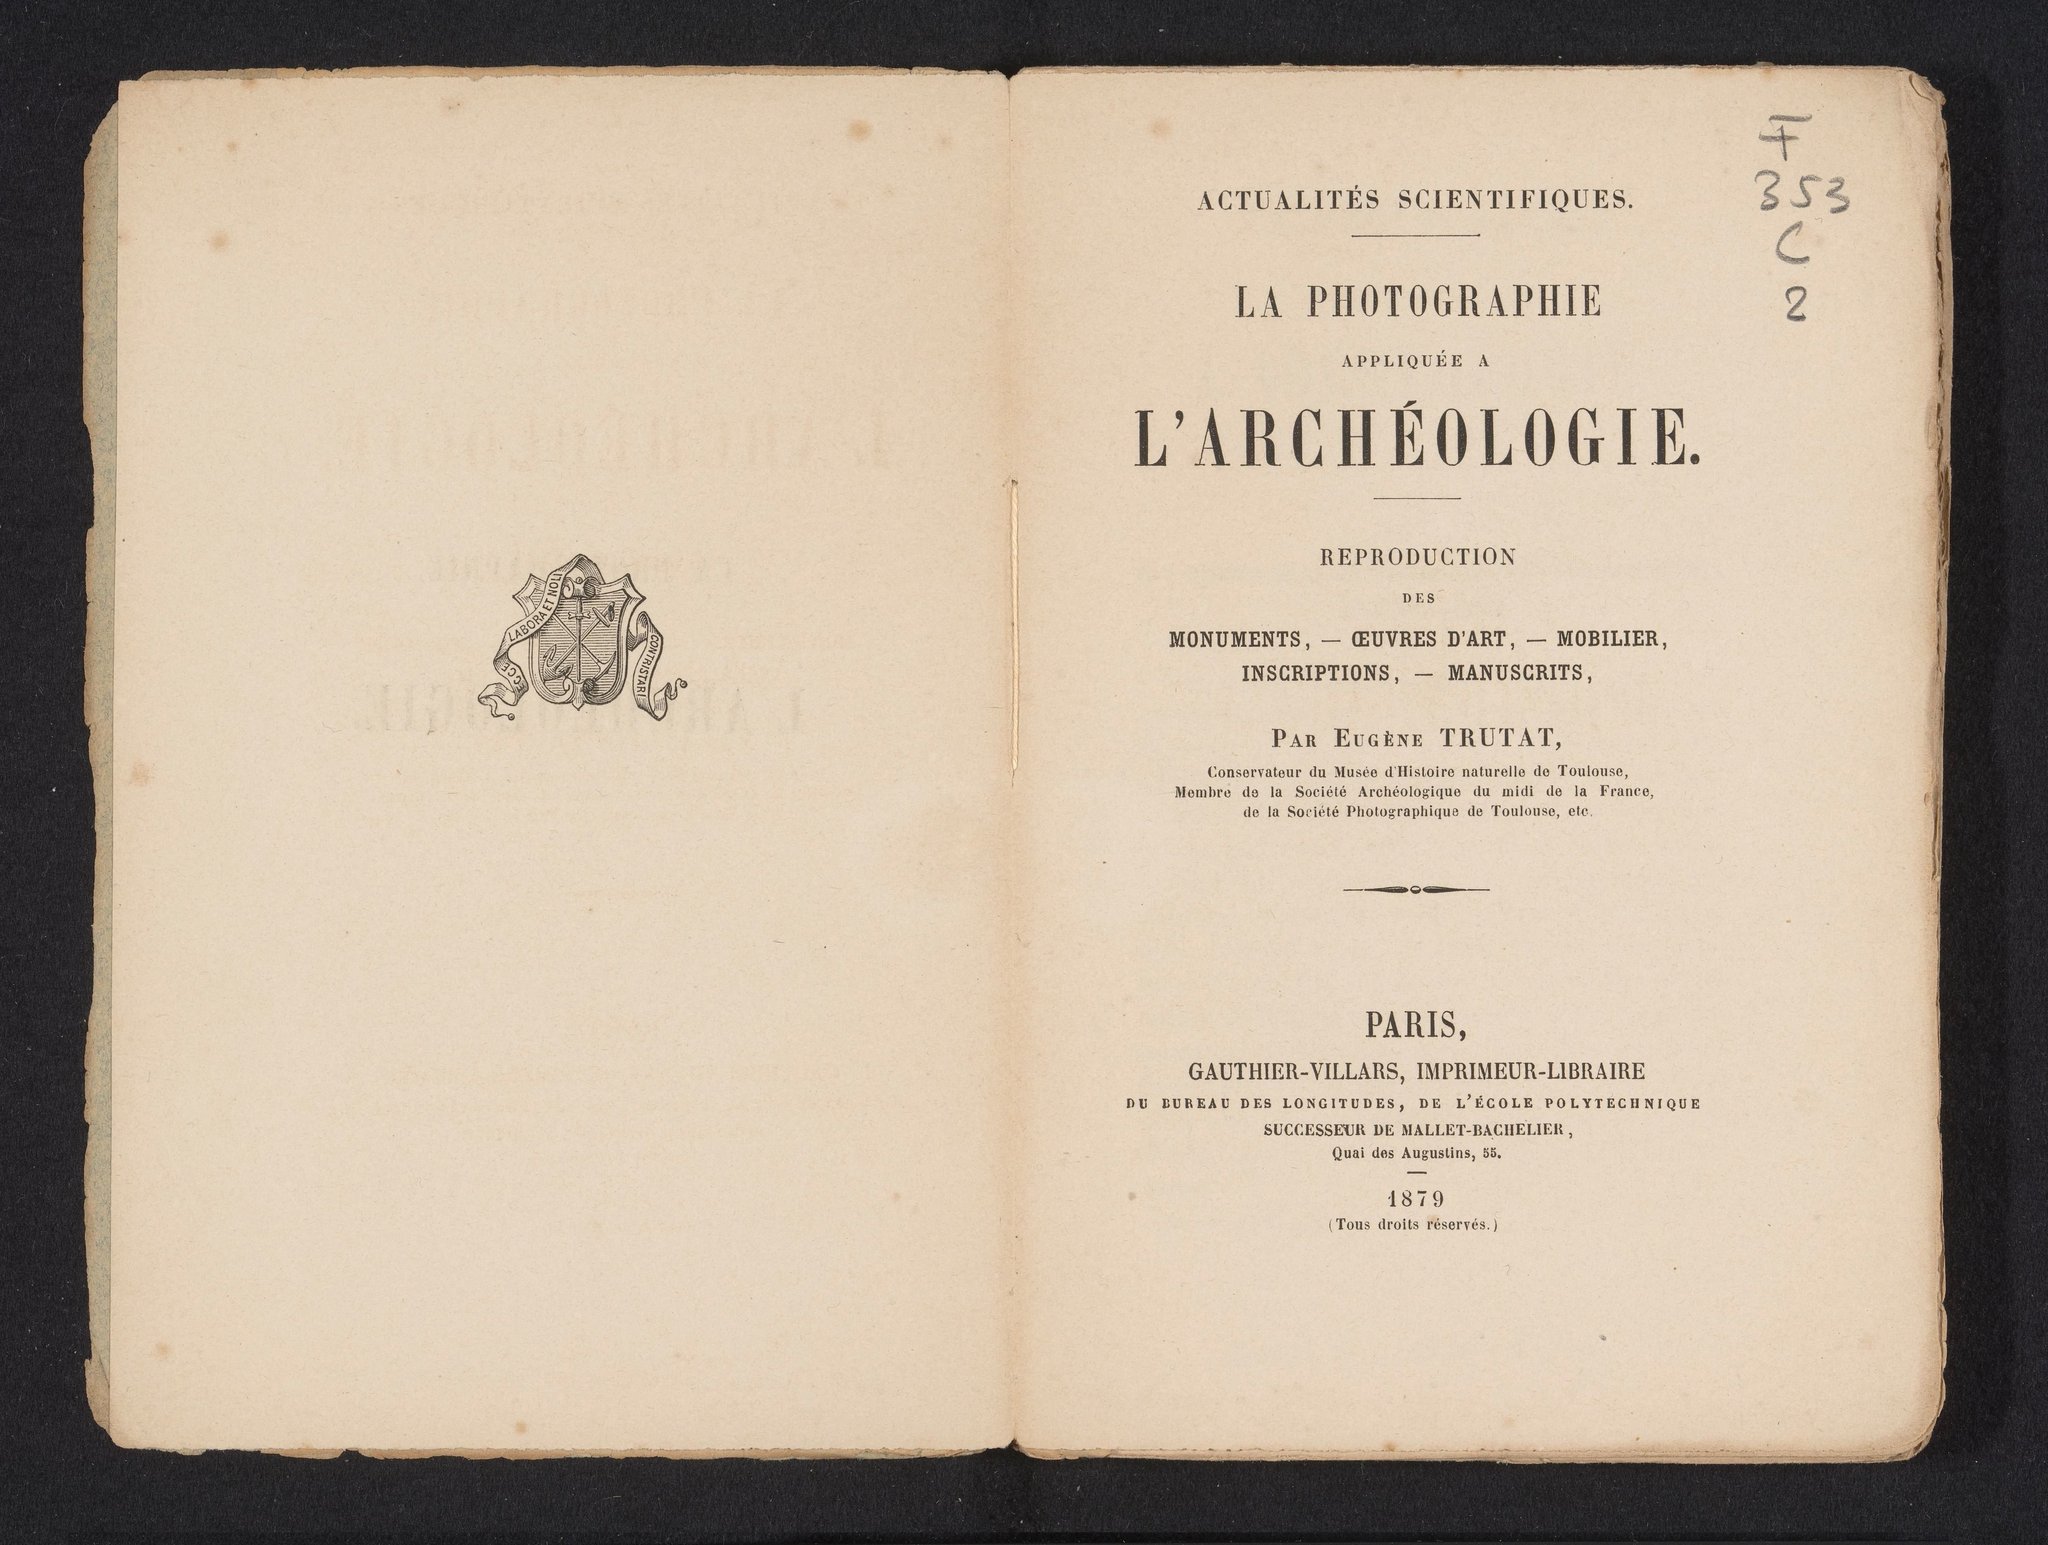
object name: book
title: La photographie appliquée à l'archéologie réproductions des monuments, oeuvres d'art, mobilier, inscriptions, manuscrits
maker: eugène trutat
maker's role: fotograaf, geoloog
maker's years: 1840-1910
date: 1879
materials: paper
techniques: photograph, engraving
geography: paris